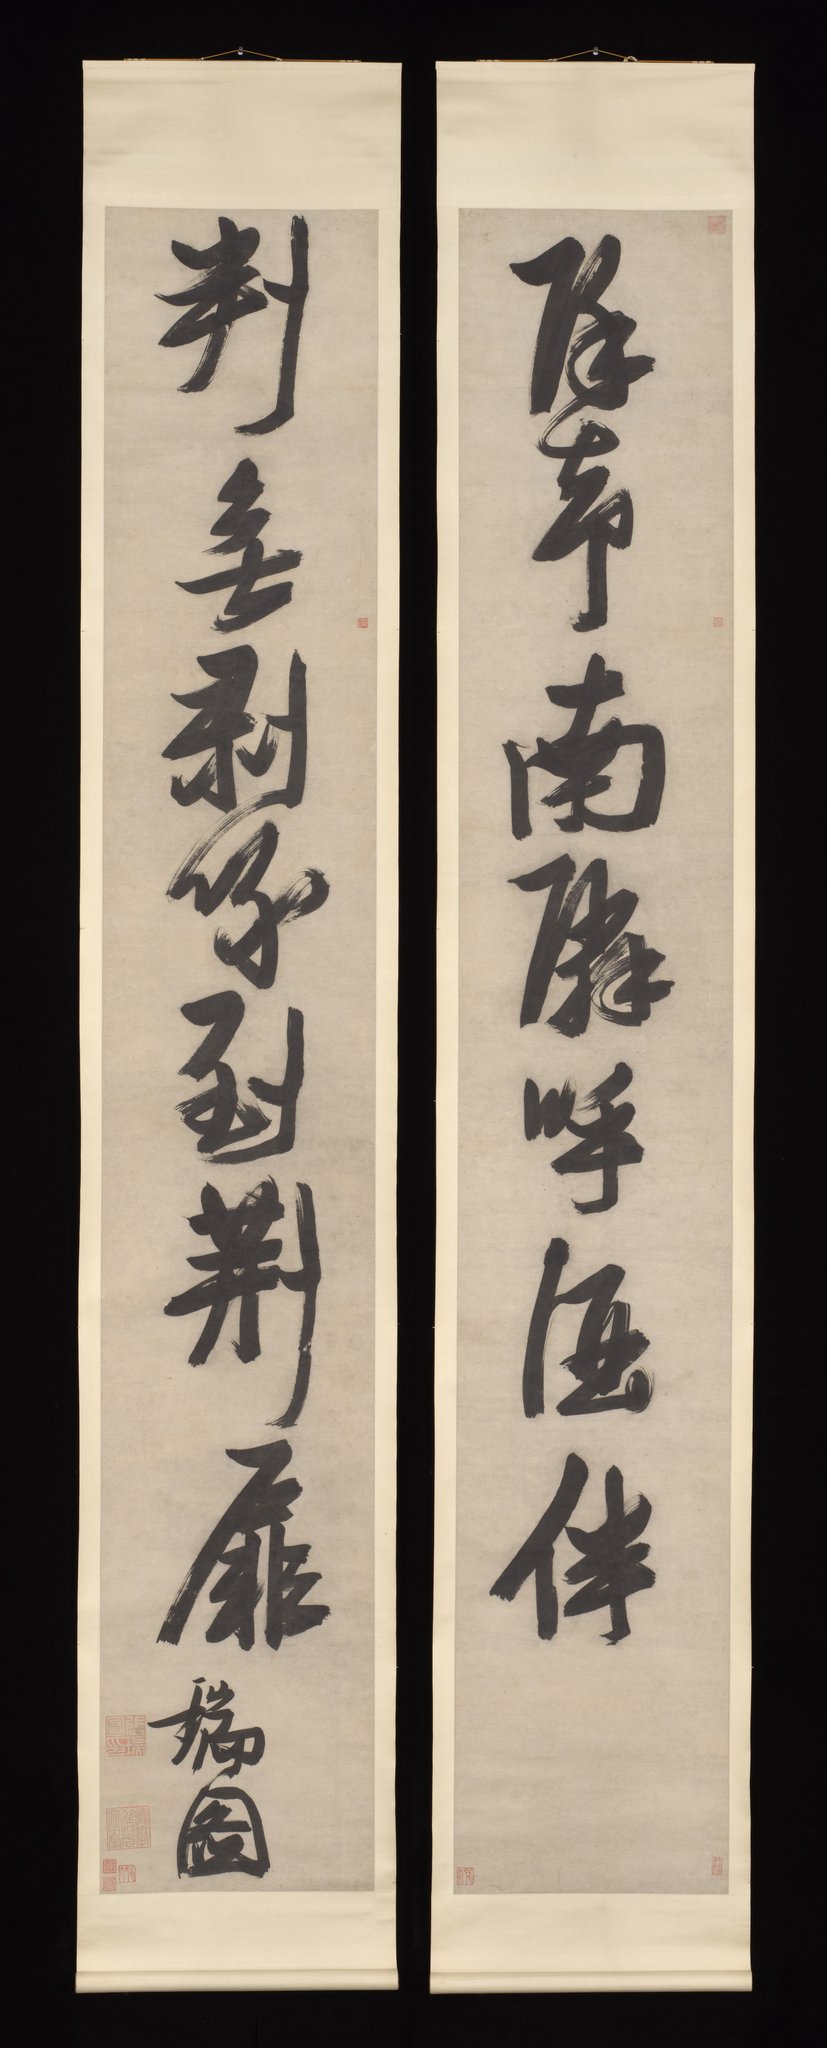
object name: hanging scroll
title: Couplet in Seven-character Meter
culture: chinese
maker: zhang ruitu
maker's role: artist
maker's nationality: chinese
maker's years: 1570-1641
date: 1570-1641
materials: ink, paper